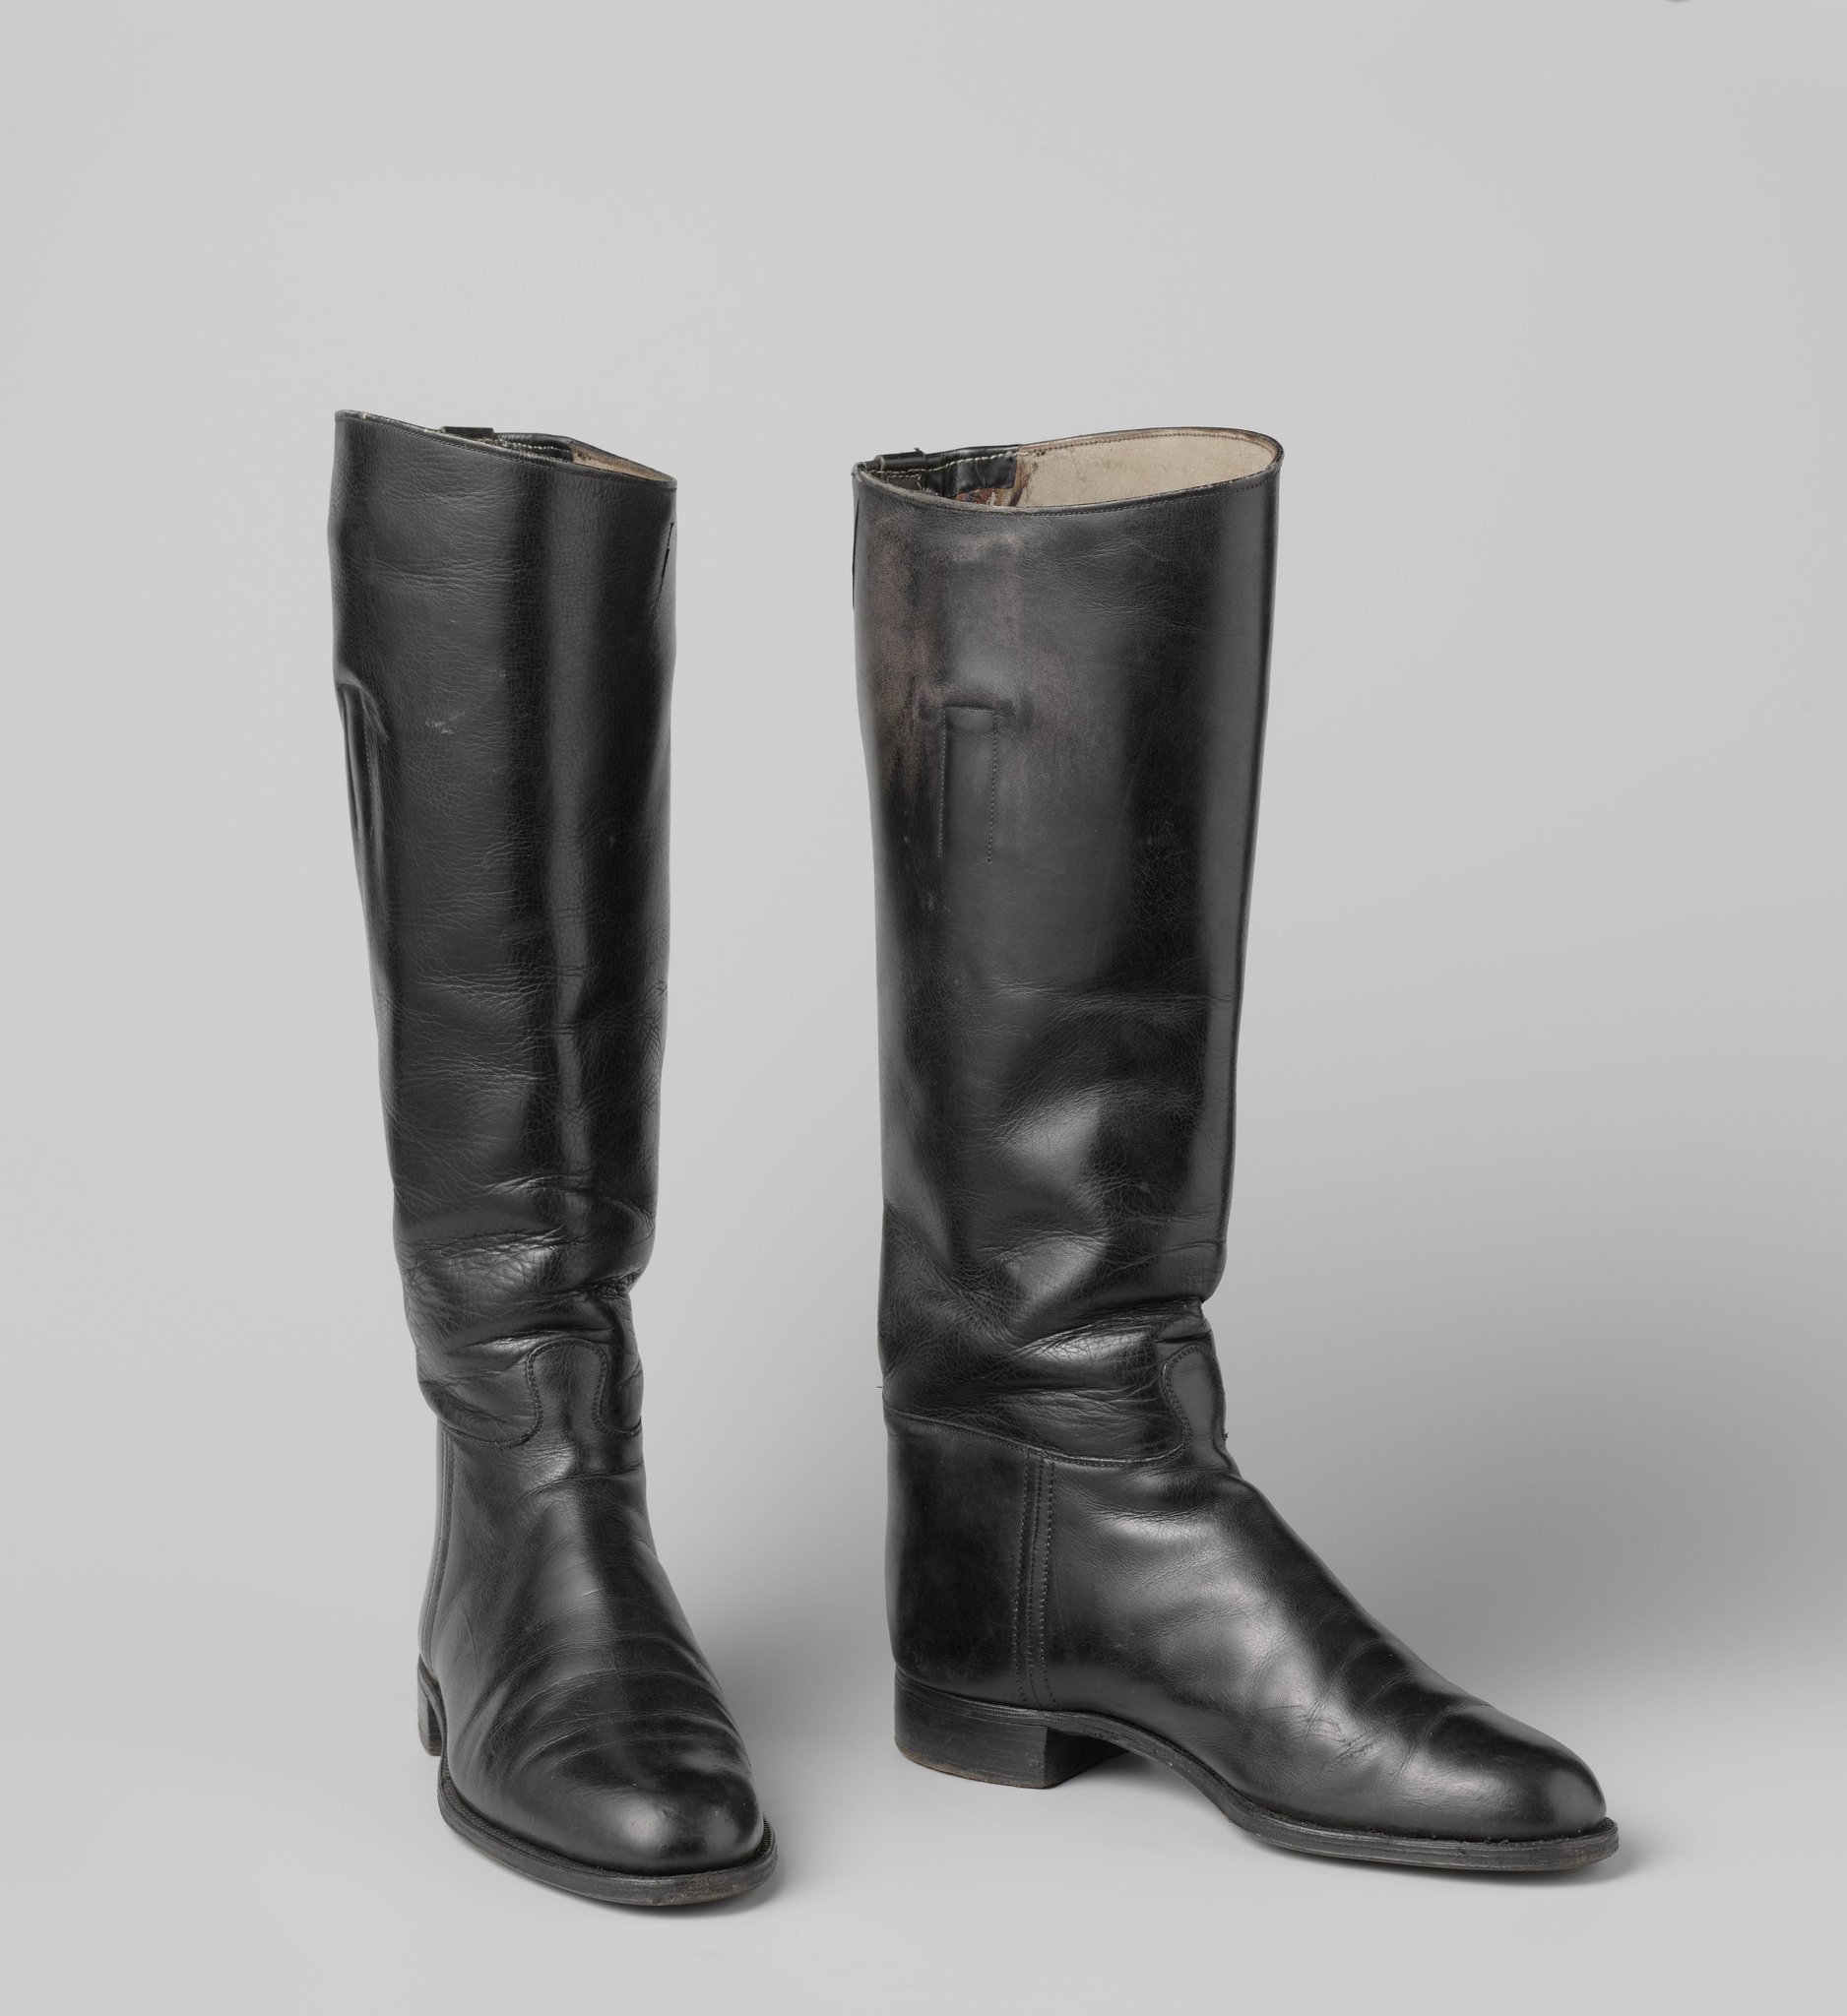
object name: sport clothing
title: Rijlaars van een rijkostuum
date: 1934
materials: leather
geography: netherlands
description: Linkerrijlaars, deel van een paar, behorende bij een rijkostuum, van zwart leer gevoerd met naturelkleurig leer. Adres: FRANSSEN/AMSTERDAM/LEIDSCHESTRAAT 80/H/.PRINSENGR.